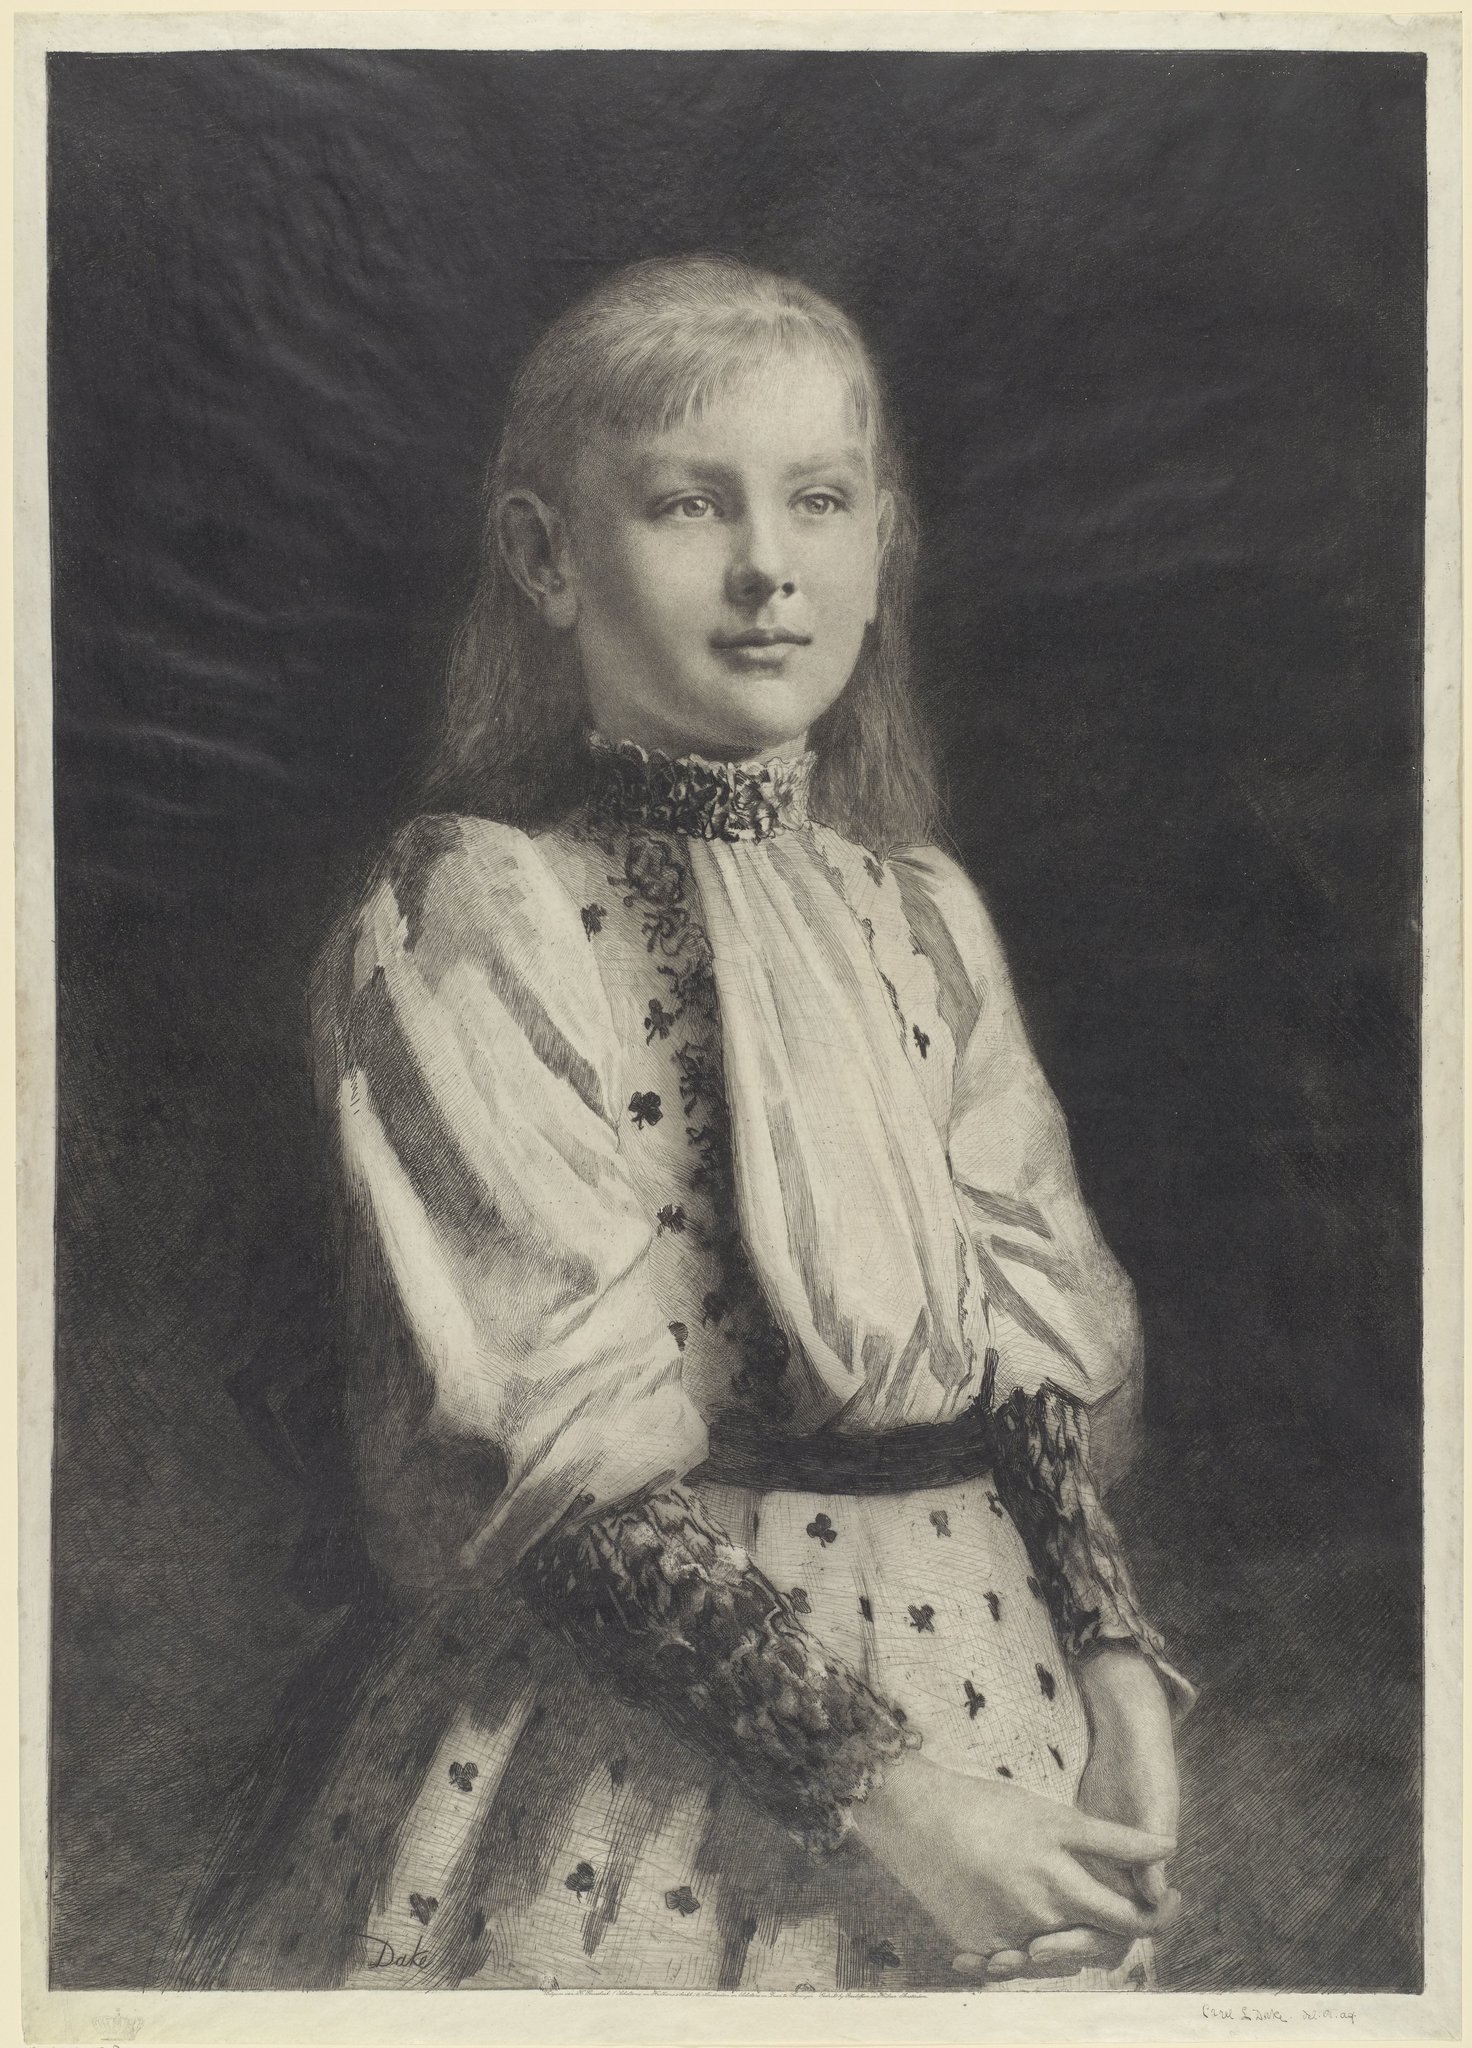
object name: print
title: Portret van Wilhelmina, koningin der Nederlanden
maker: carel lodewijk dake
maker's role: draughtsman, painter, print maker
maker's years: 1857-1918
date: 1885-1918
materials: paper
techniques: drypoint, etching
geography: amsterdam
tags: the hague, print maker, wilhelmina of the netherlands, historical persons - bb - woman, ranks ~ rulers, sovereigns - bb - female ruler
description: De hier vermelde titel verwijst naar de hoogst verkregen titel van de geportretteerde, niet per se naar de titel die de geportretteerde op deze voorstelling draagt.